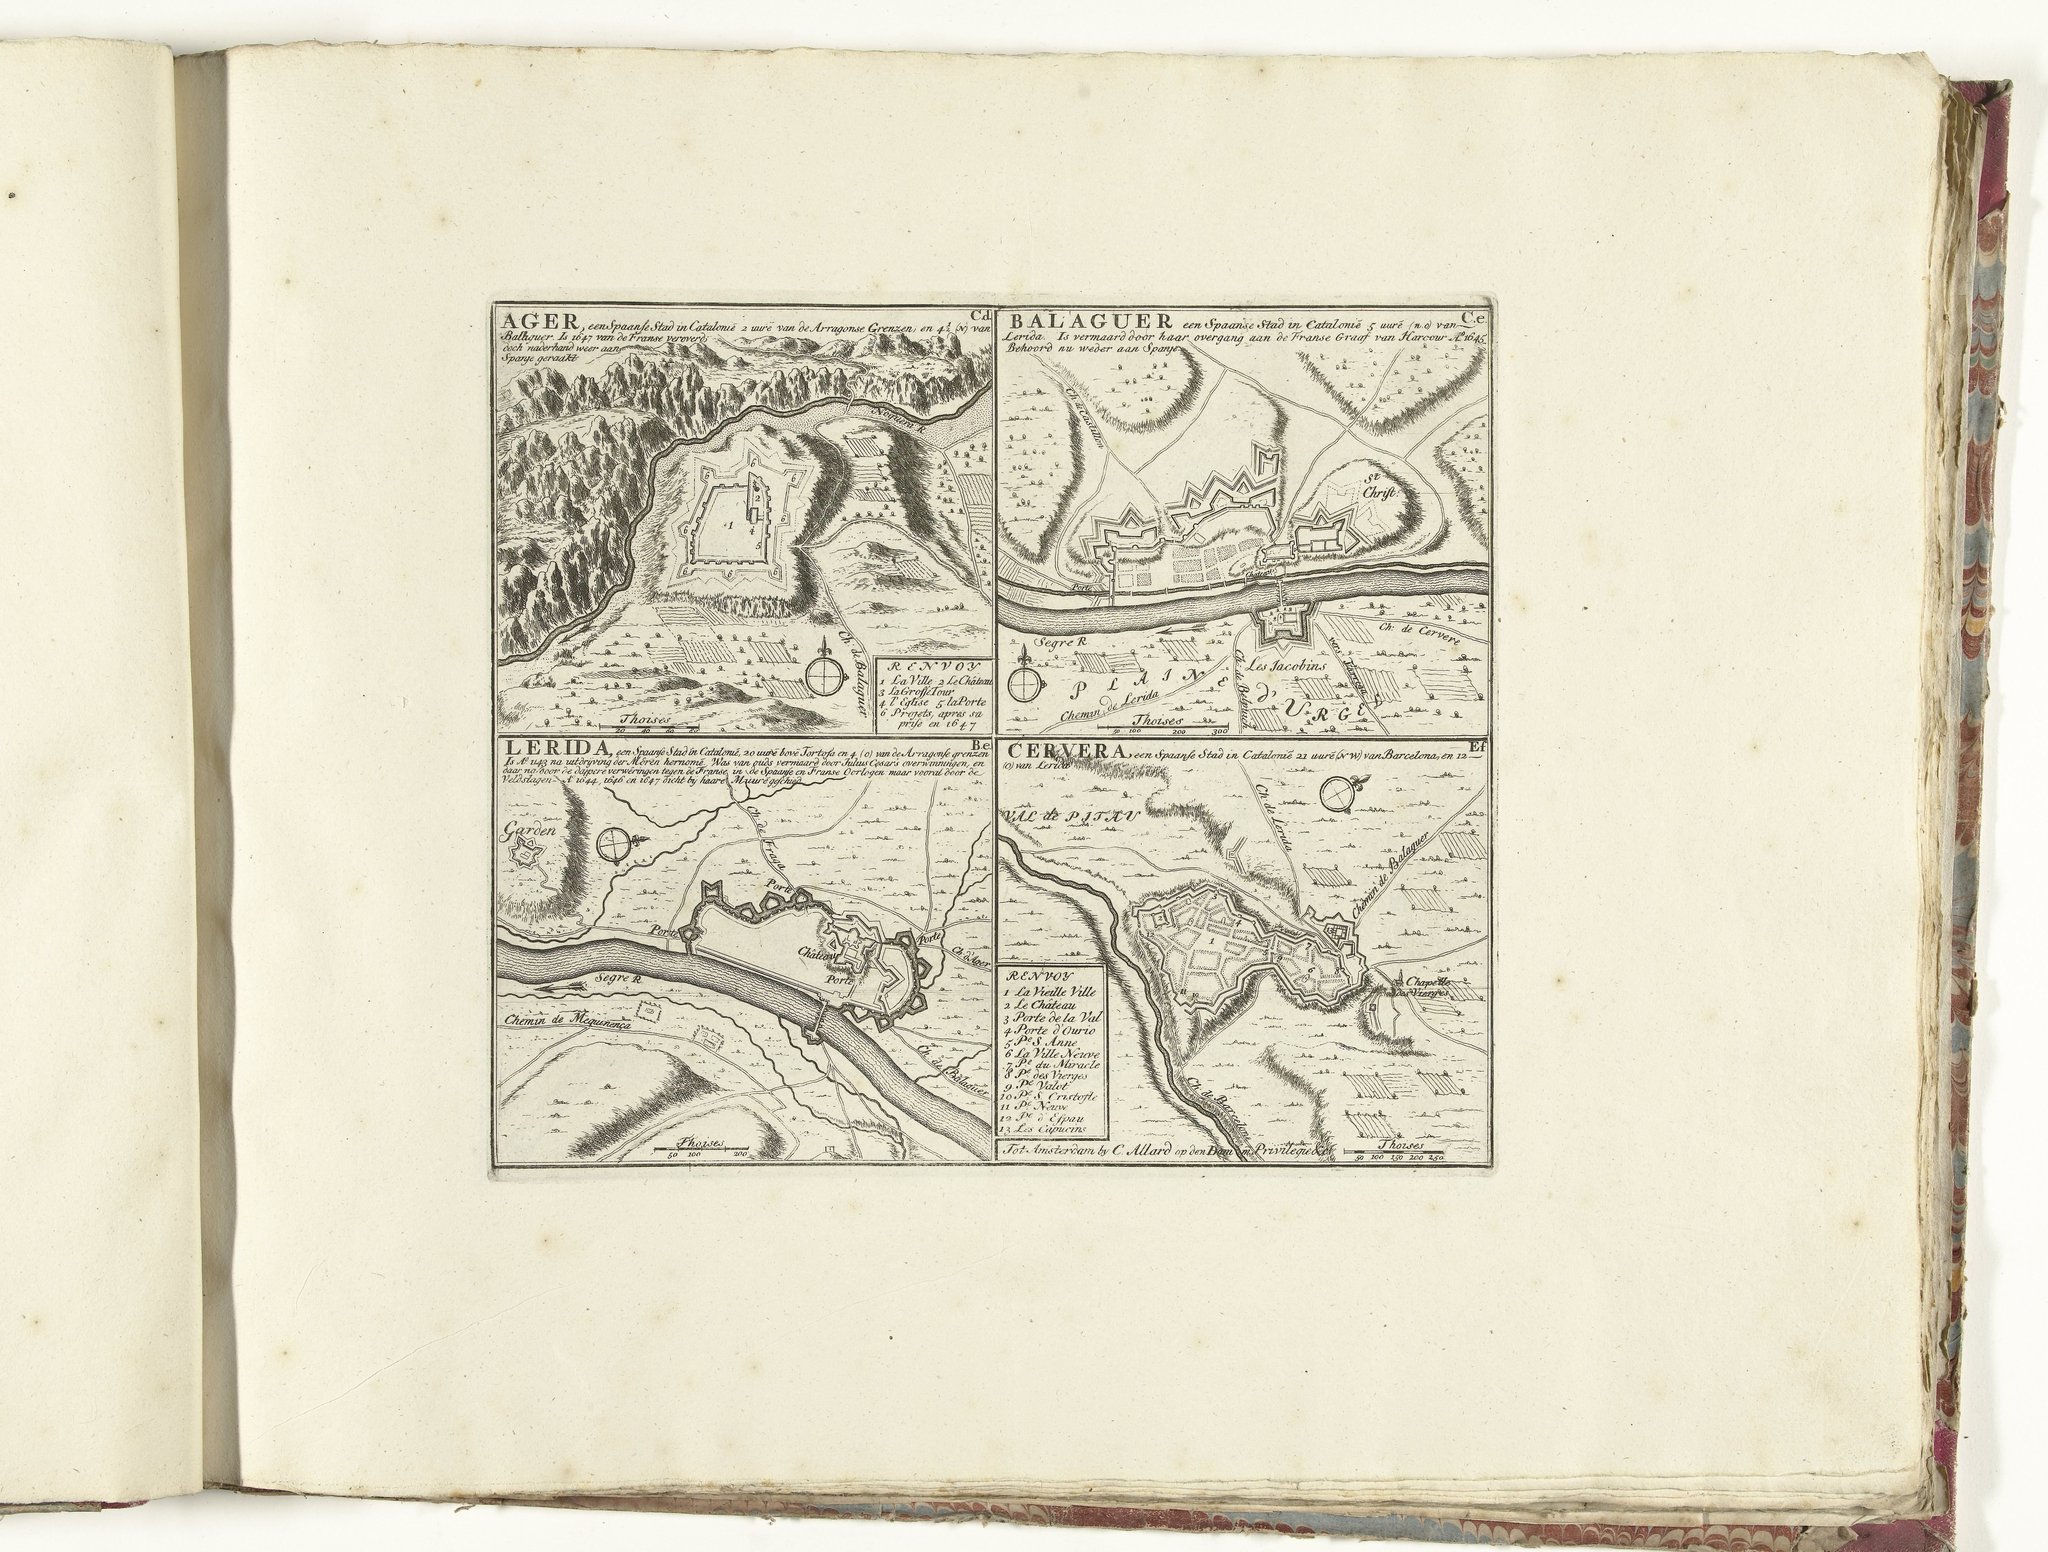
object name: album leaf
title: Ager / Balaguer / Lerida / Cervera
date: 1701-1714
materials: paper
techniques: etching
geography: france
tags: maps of cities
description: Gekopieerd naar de Franse prenten in: Nicolas de Fer, Les forces de l'Europe, ou description des principales villes, avec leurs fortifications : dessignées par les meilleurs ingenieurs, particulierement celles ... de la France, dont les plans ont esté levez par M. de Vauban, Nicolas de Fer, Parijs 1693-1696, of andere voorbeelden.